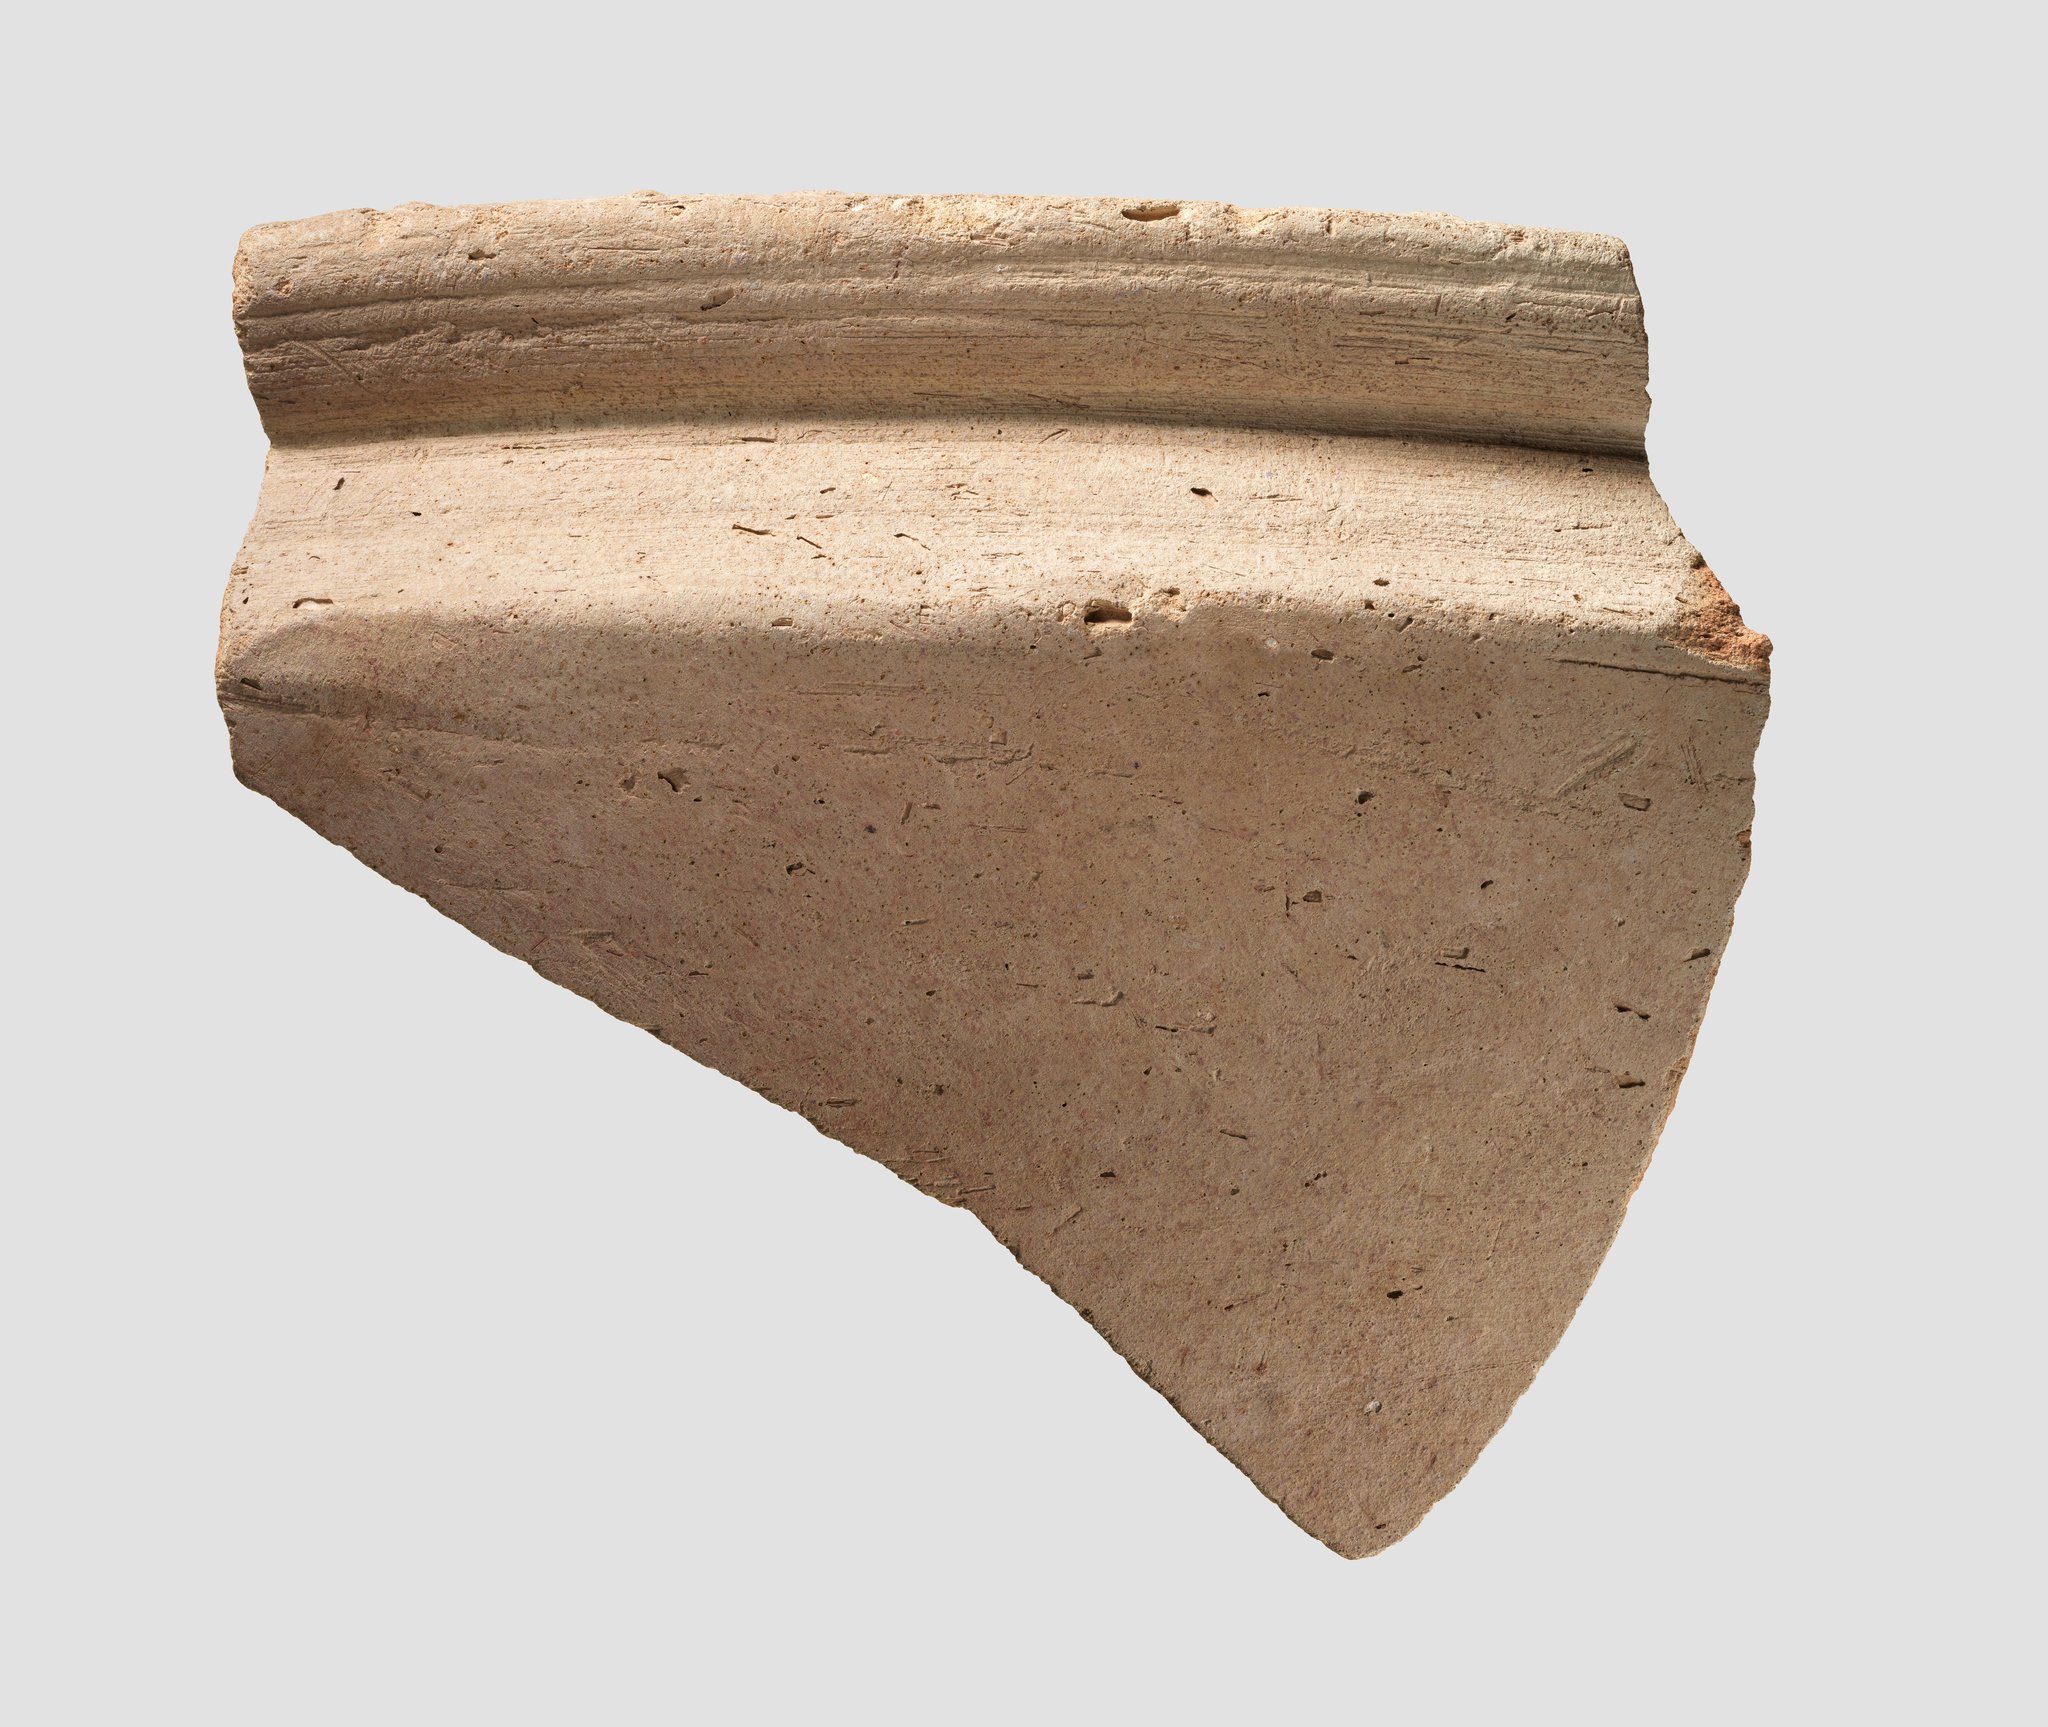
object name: bowl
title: Bowl rim sherd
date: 2333-2001 BCE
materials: ceramic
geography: mesopotamia